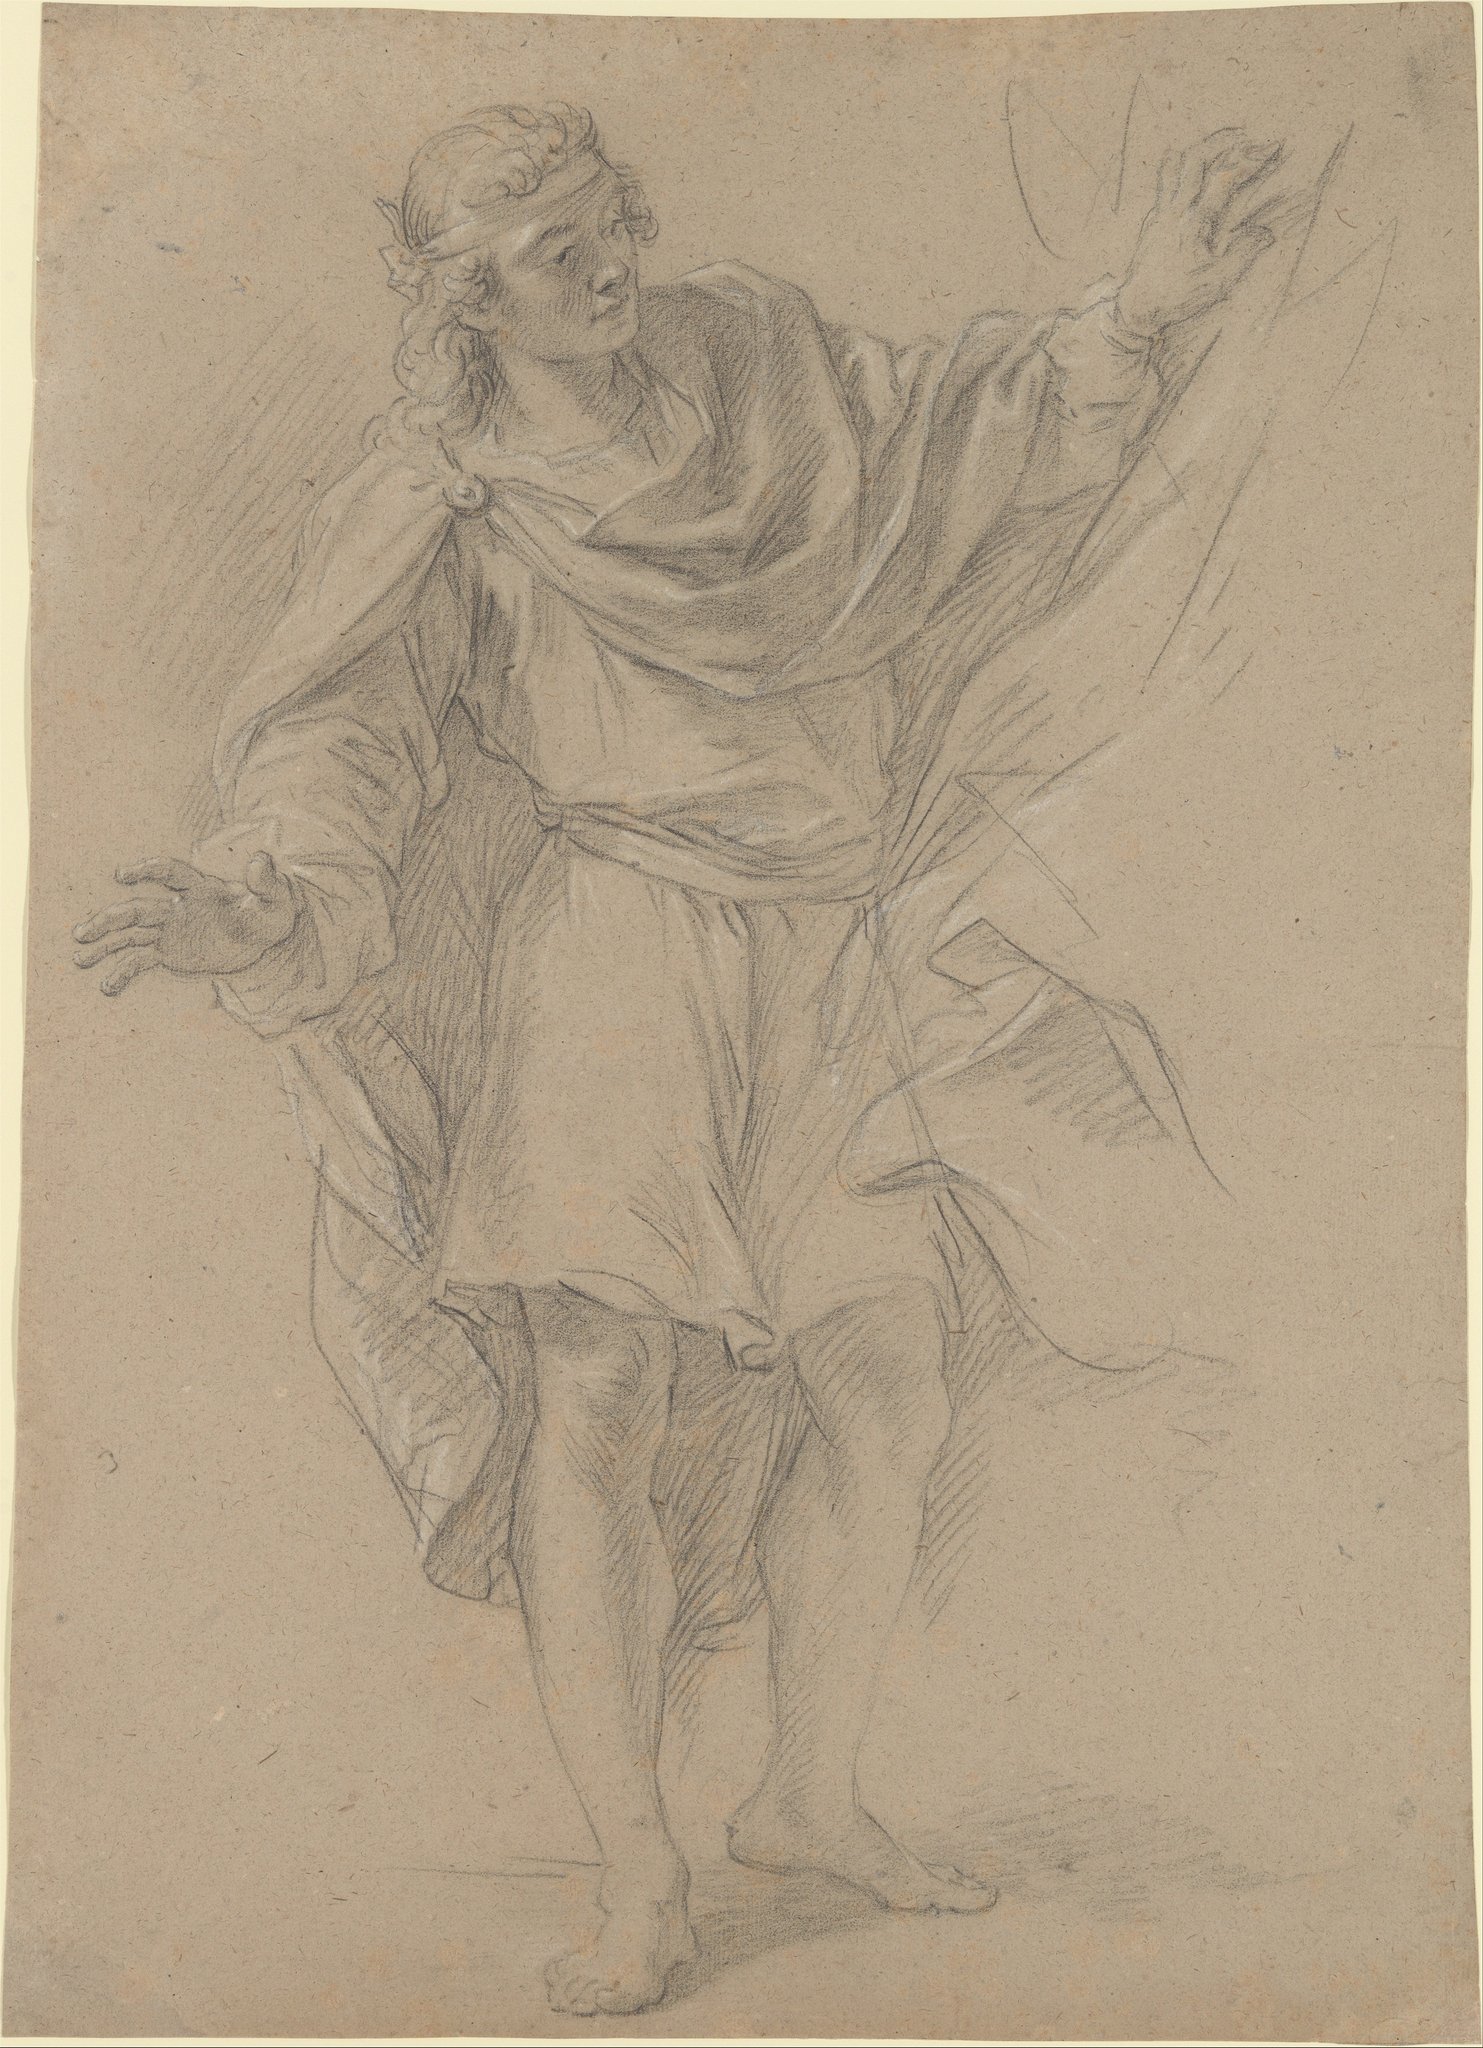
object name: drawing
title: Man Pulling a Curtain Aside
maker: etienne parrocel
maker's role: artist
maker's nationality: french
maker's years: 1696-1776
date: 1701-1800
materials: chalk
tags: men